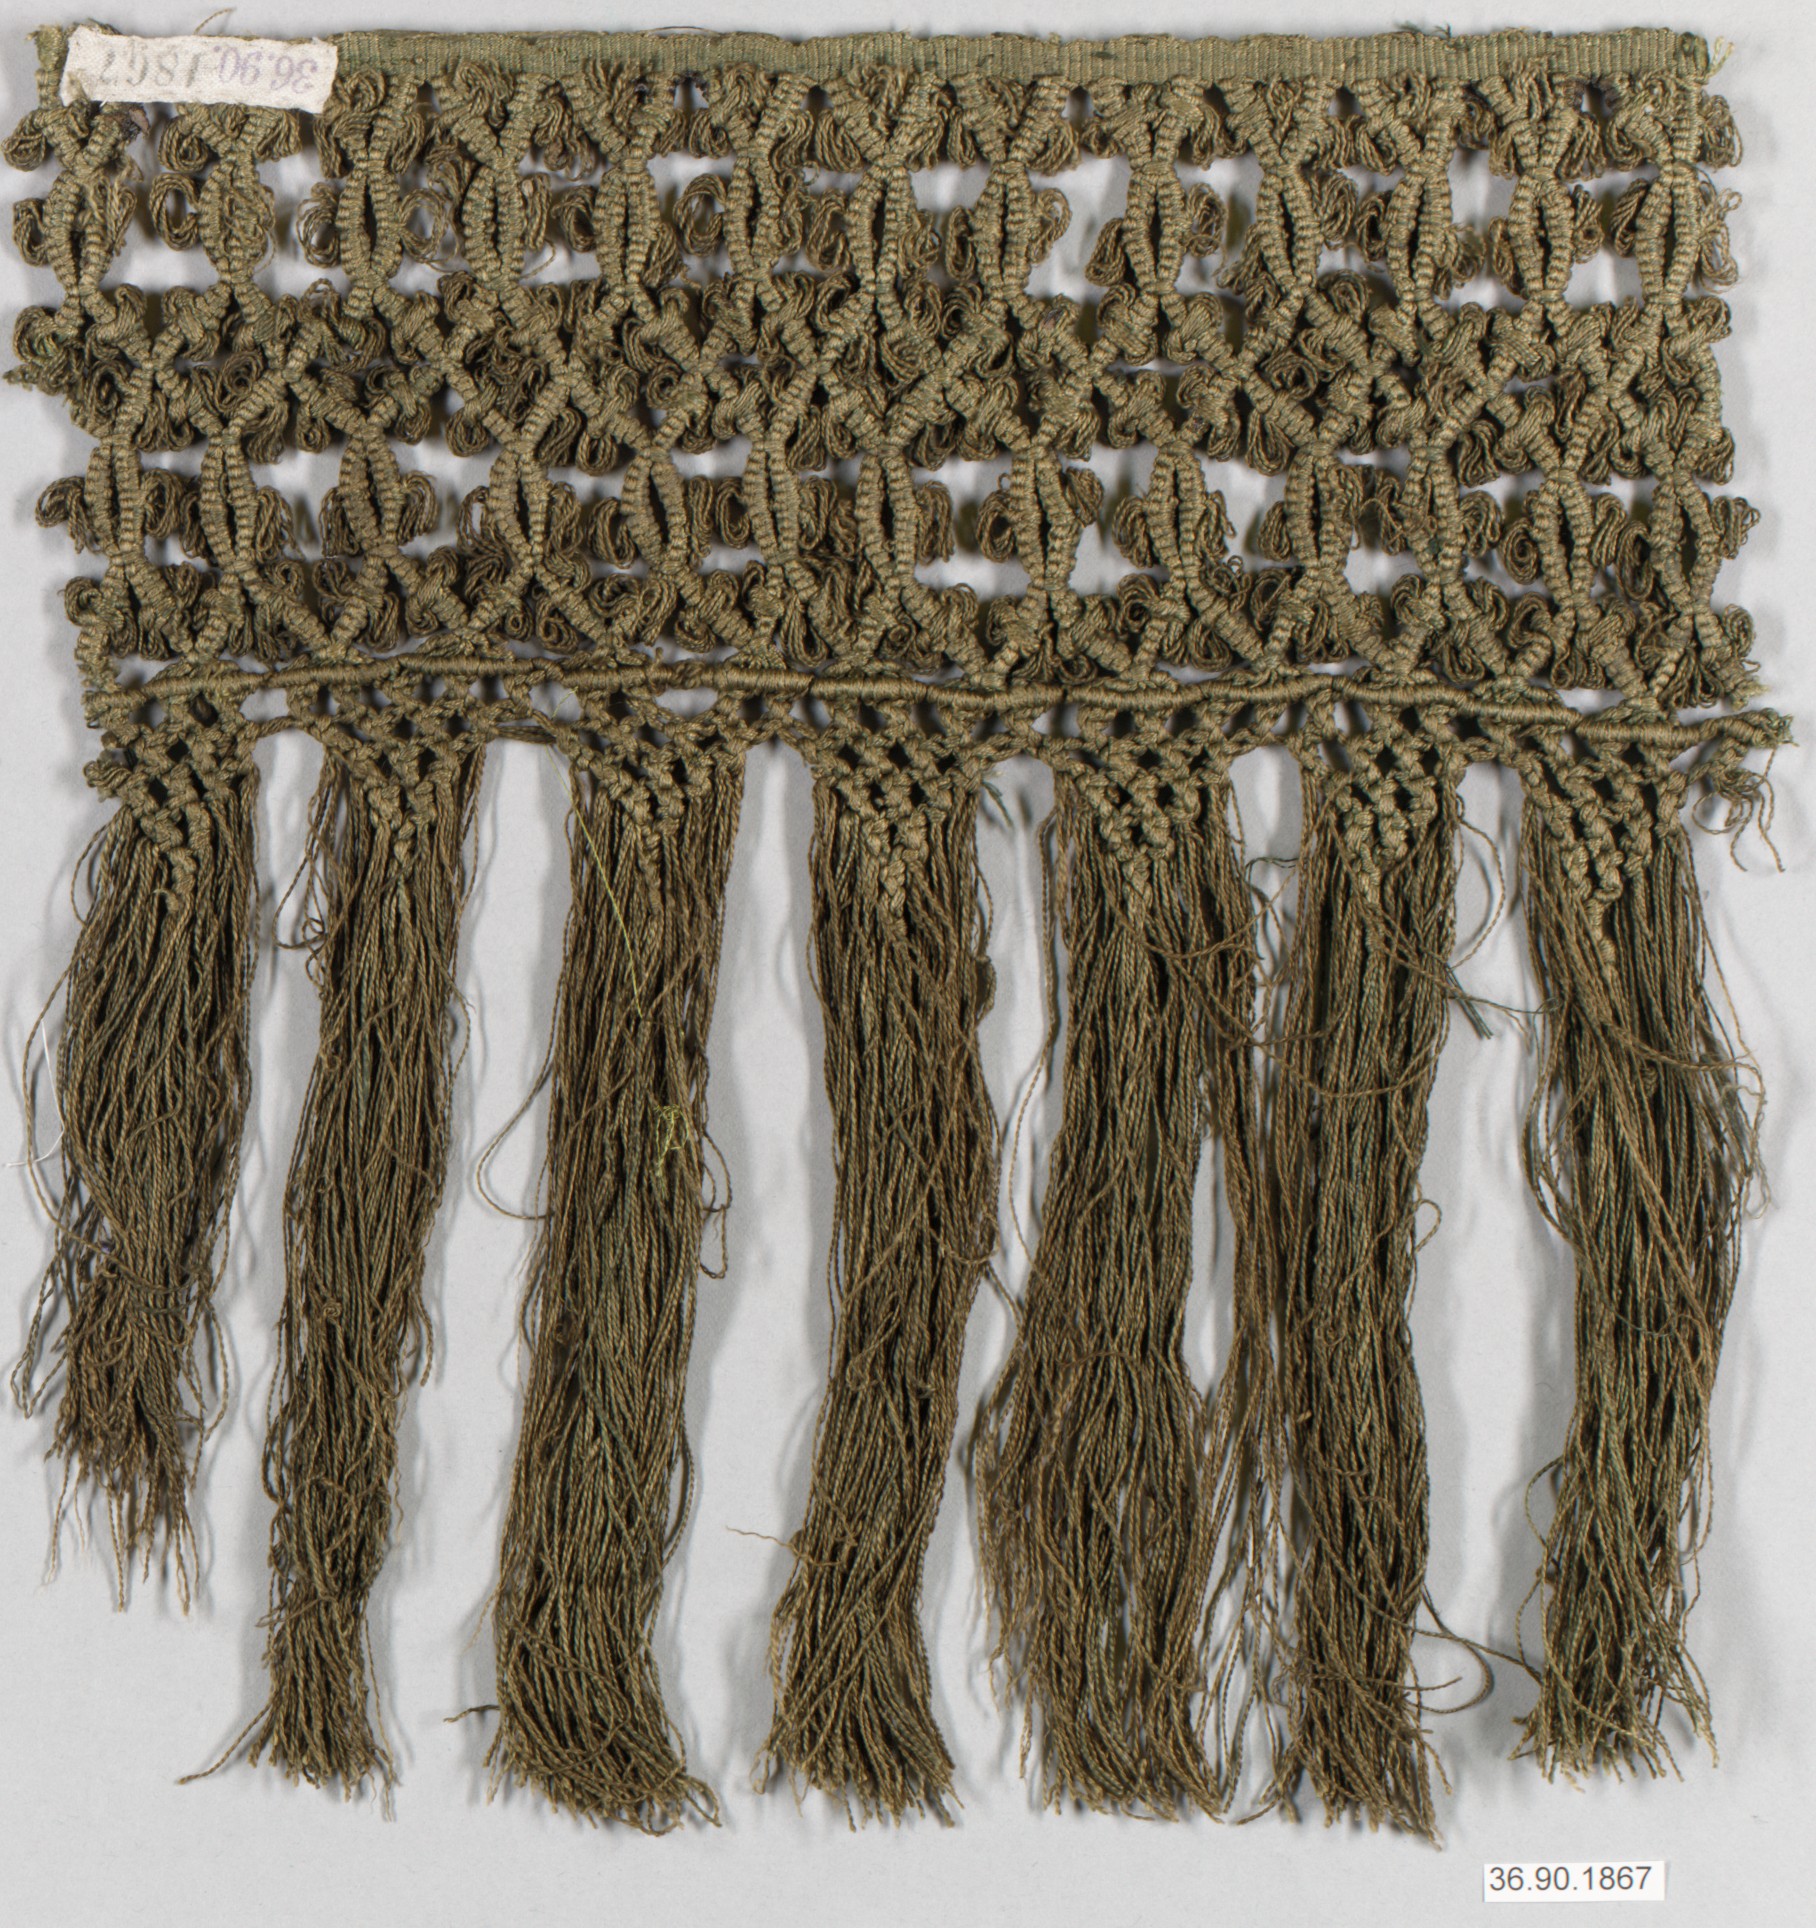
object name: fringe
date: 1801-1900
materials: silk